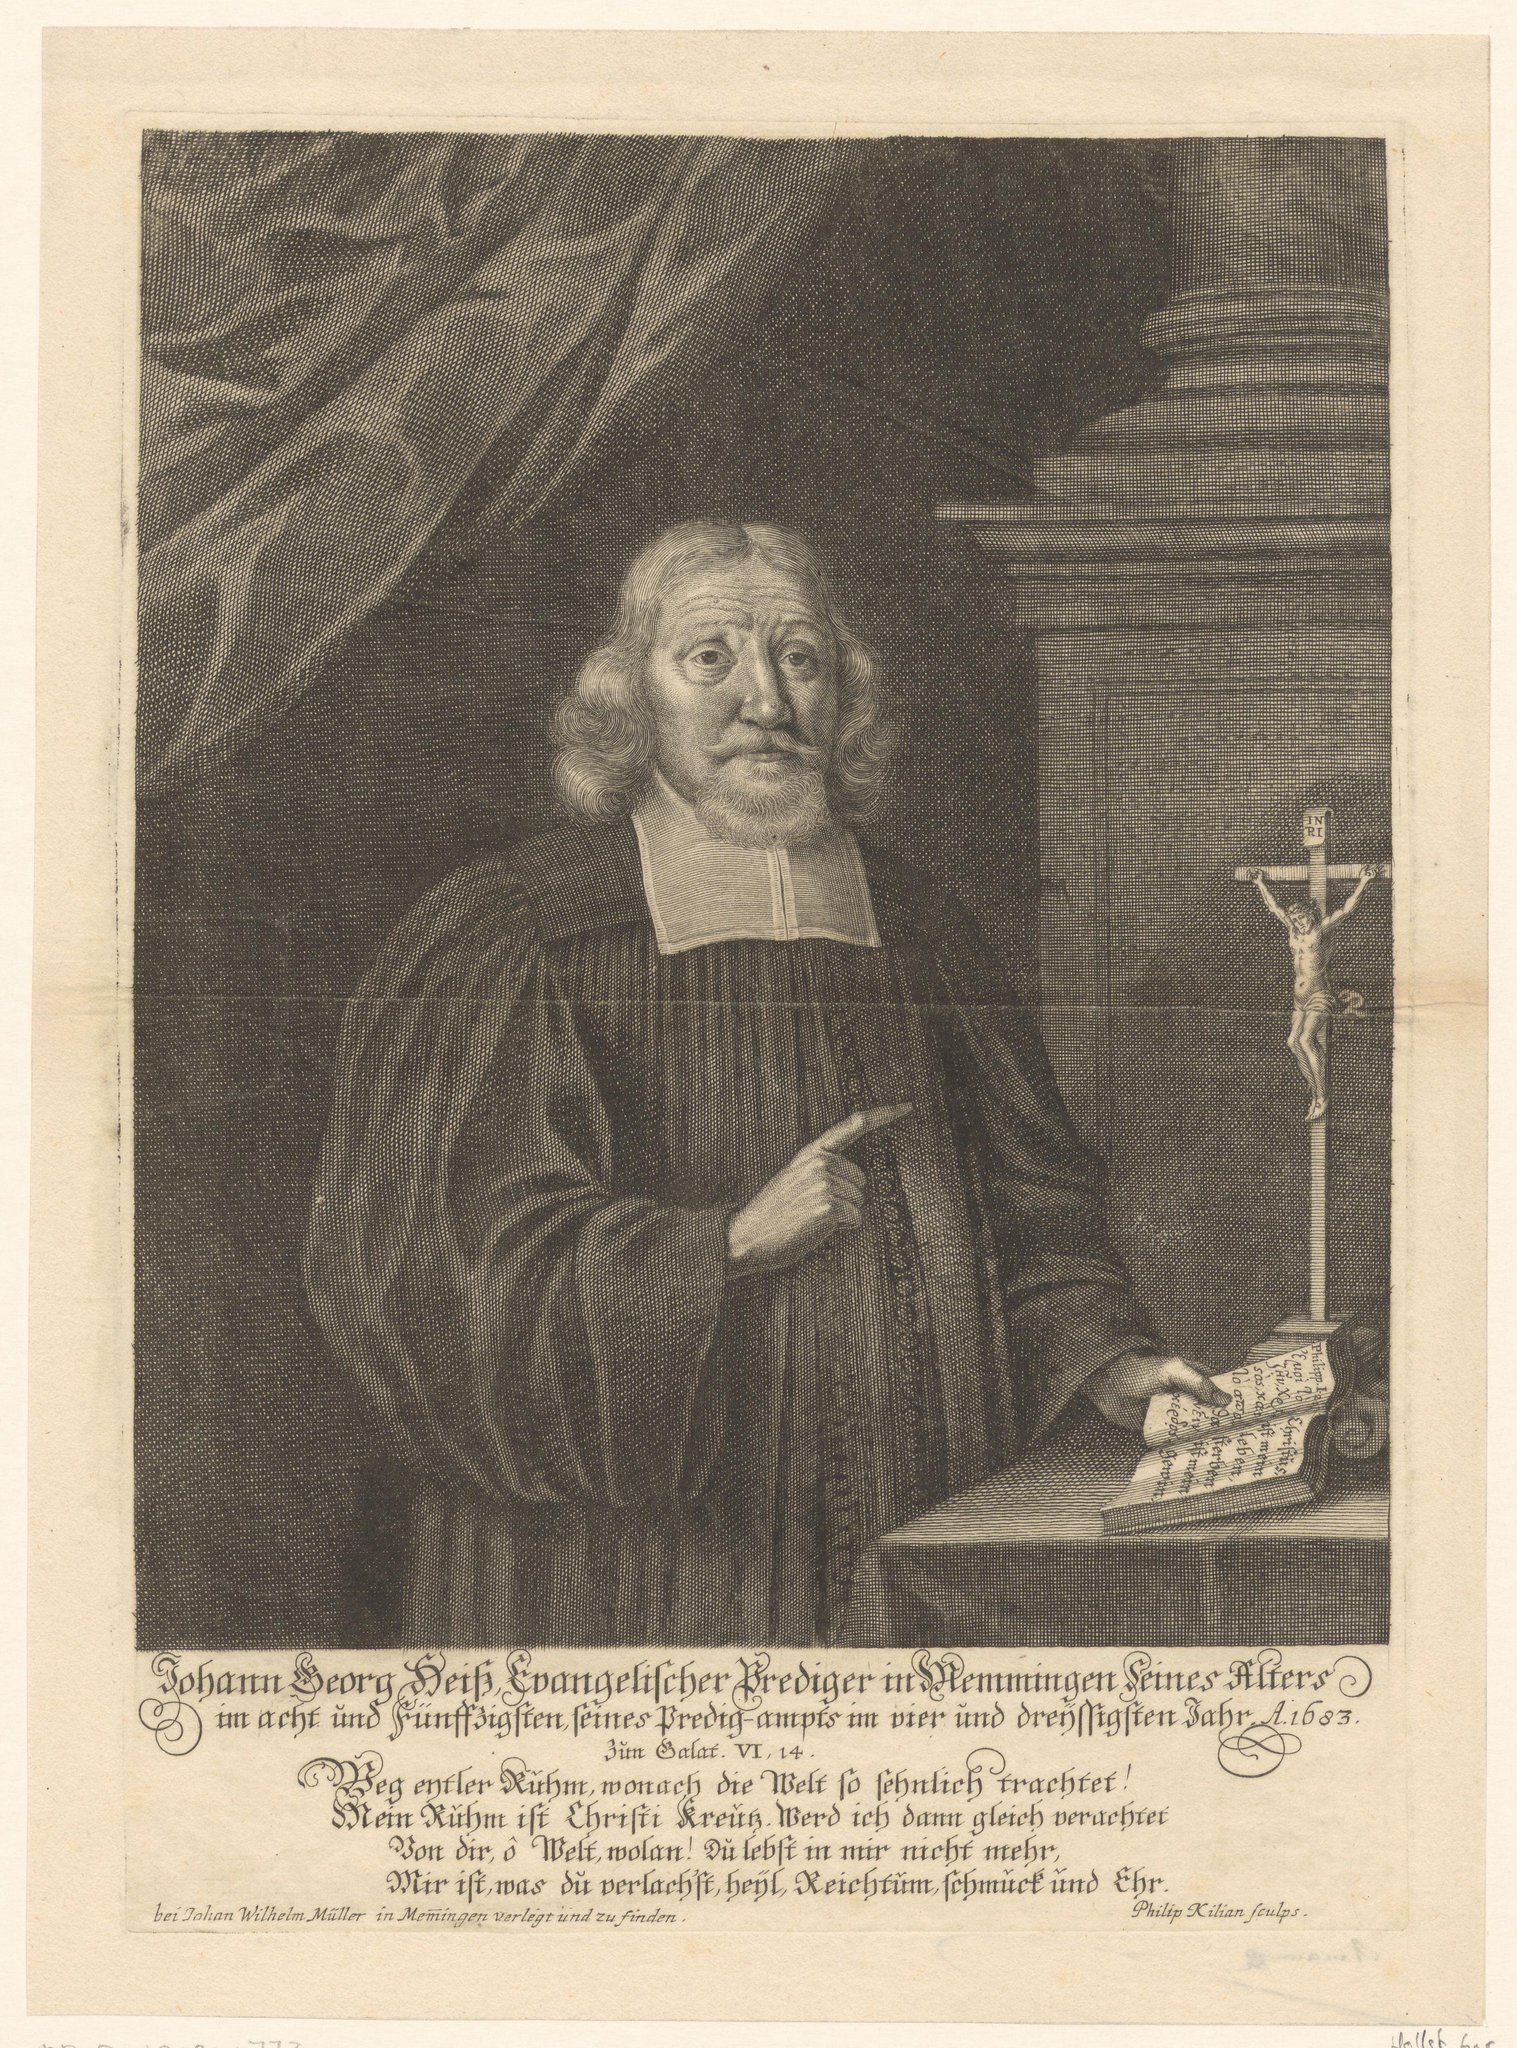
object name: print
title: Vijf portretten van priesters uit Memmingen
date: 1683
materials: paper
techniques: engraving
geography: memmingen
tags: altarcross, crucifix, theologian, historical persons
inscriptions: collector's mark: Lugt 2228